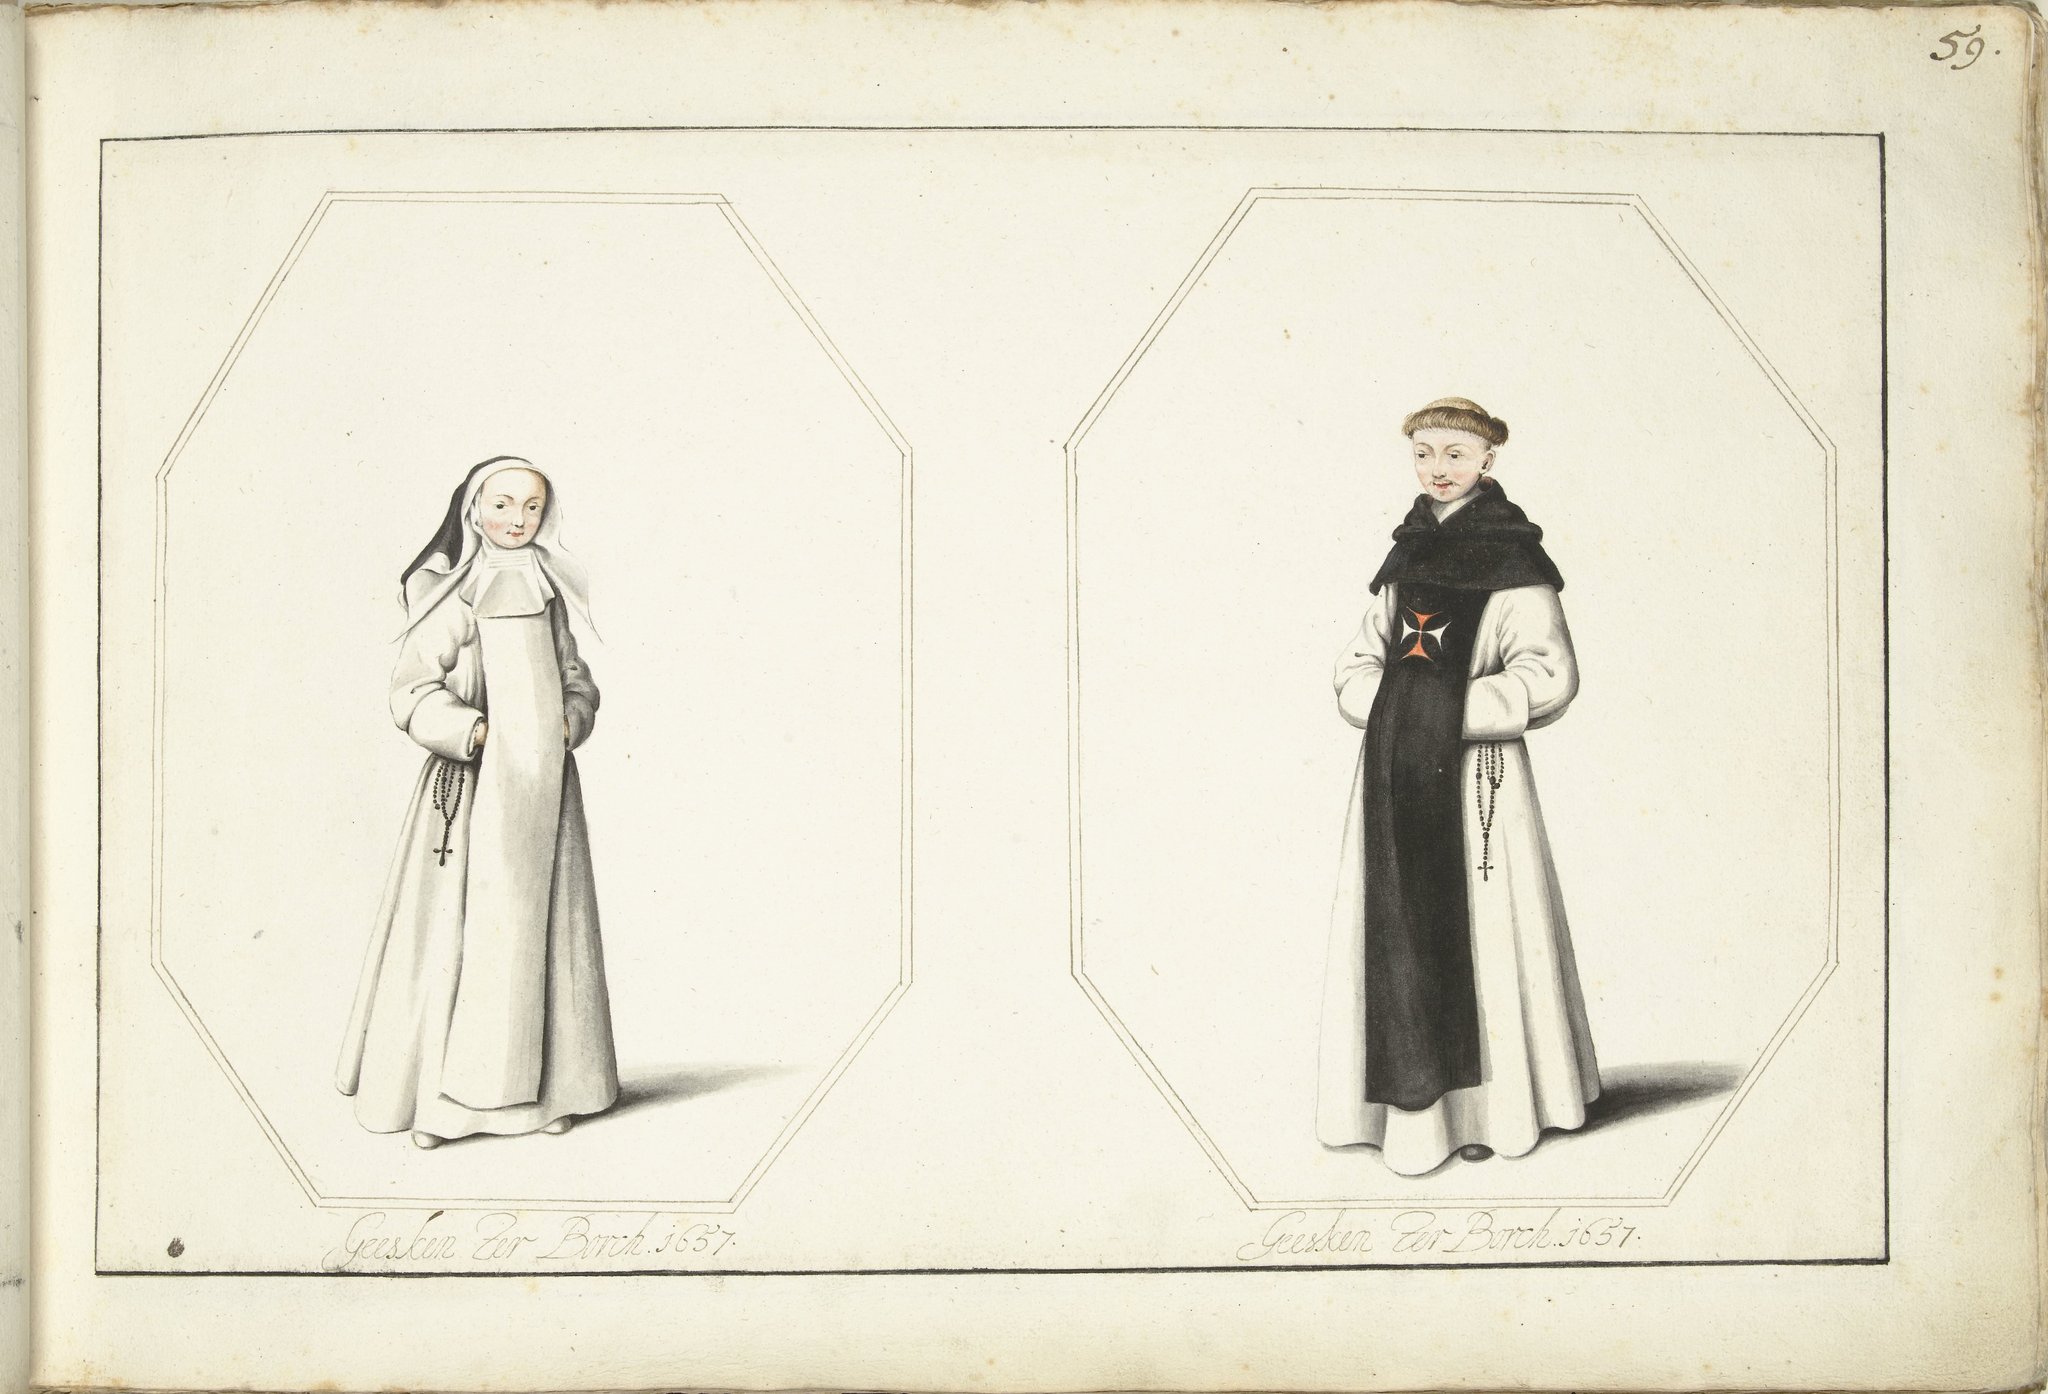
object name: drawing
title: Staande non en staande broeder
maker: gesina ter borch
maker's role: draughtsman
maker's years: 1633-1690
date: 1657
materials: paper, watercolor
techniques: brush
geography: zwolle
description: De monnik draagt de habijt van de Orde van het Heilig Kruis (de Kruisheren).